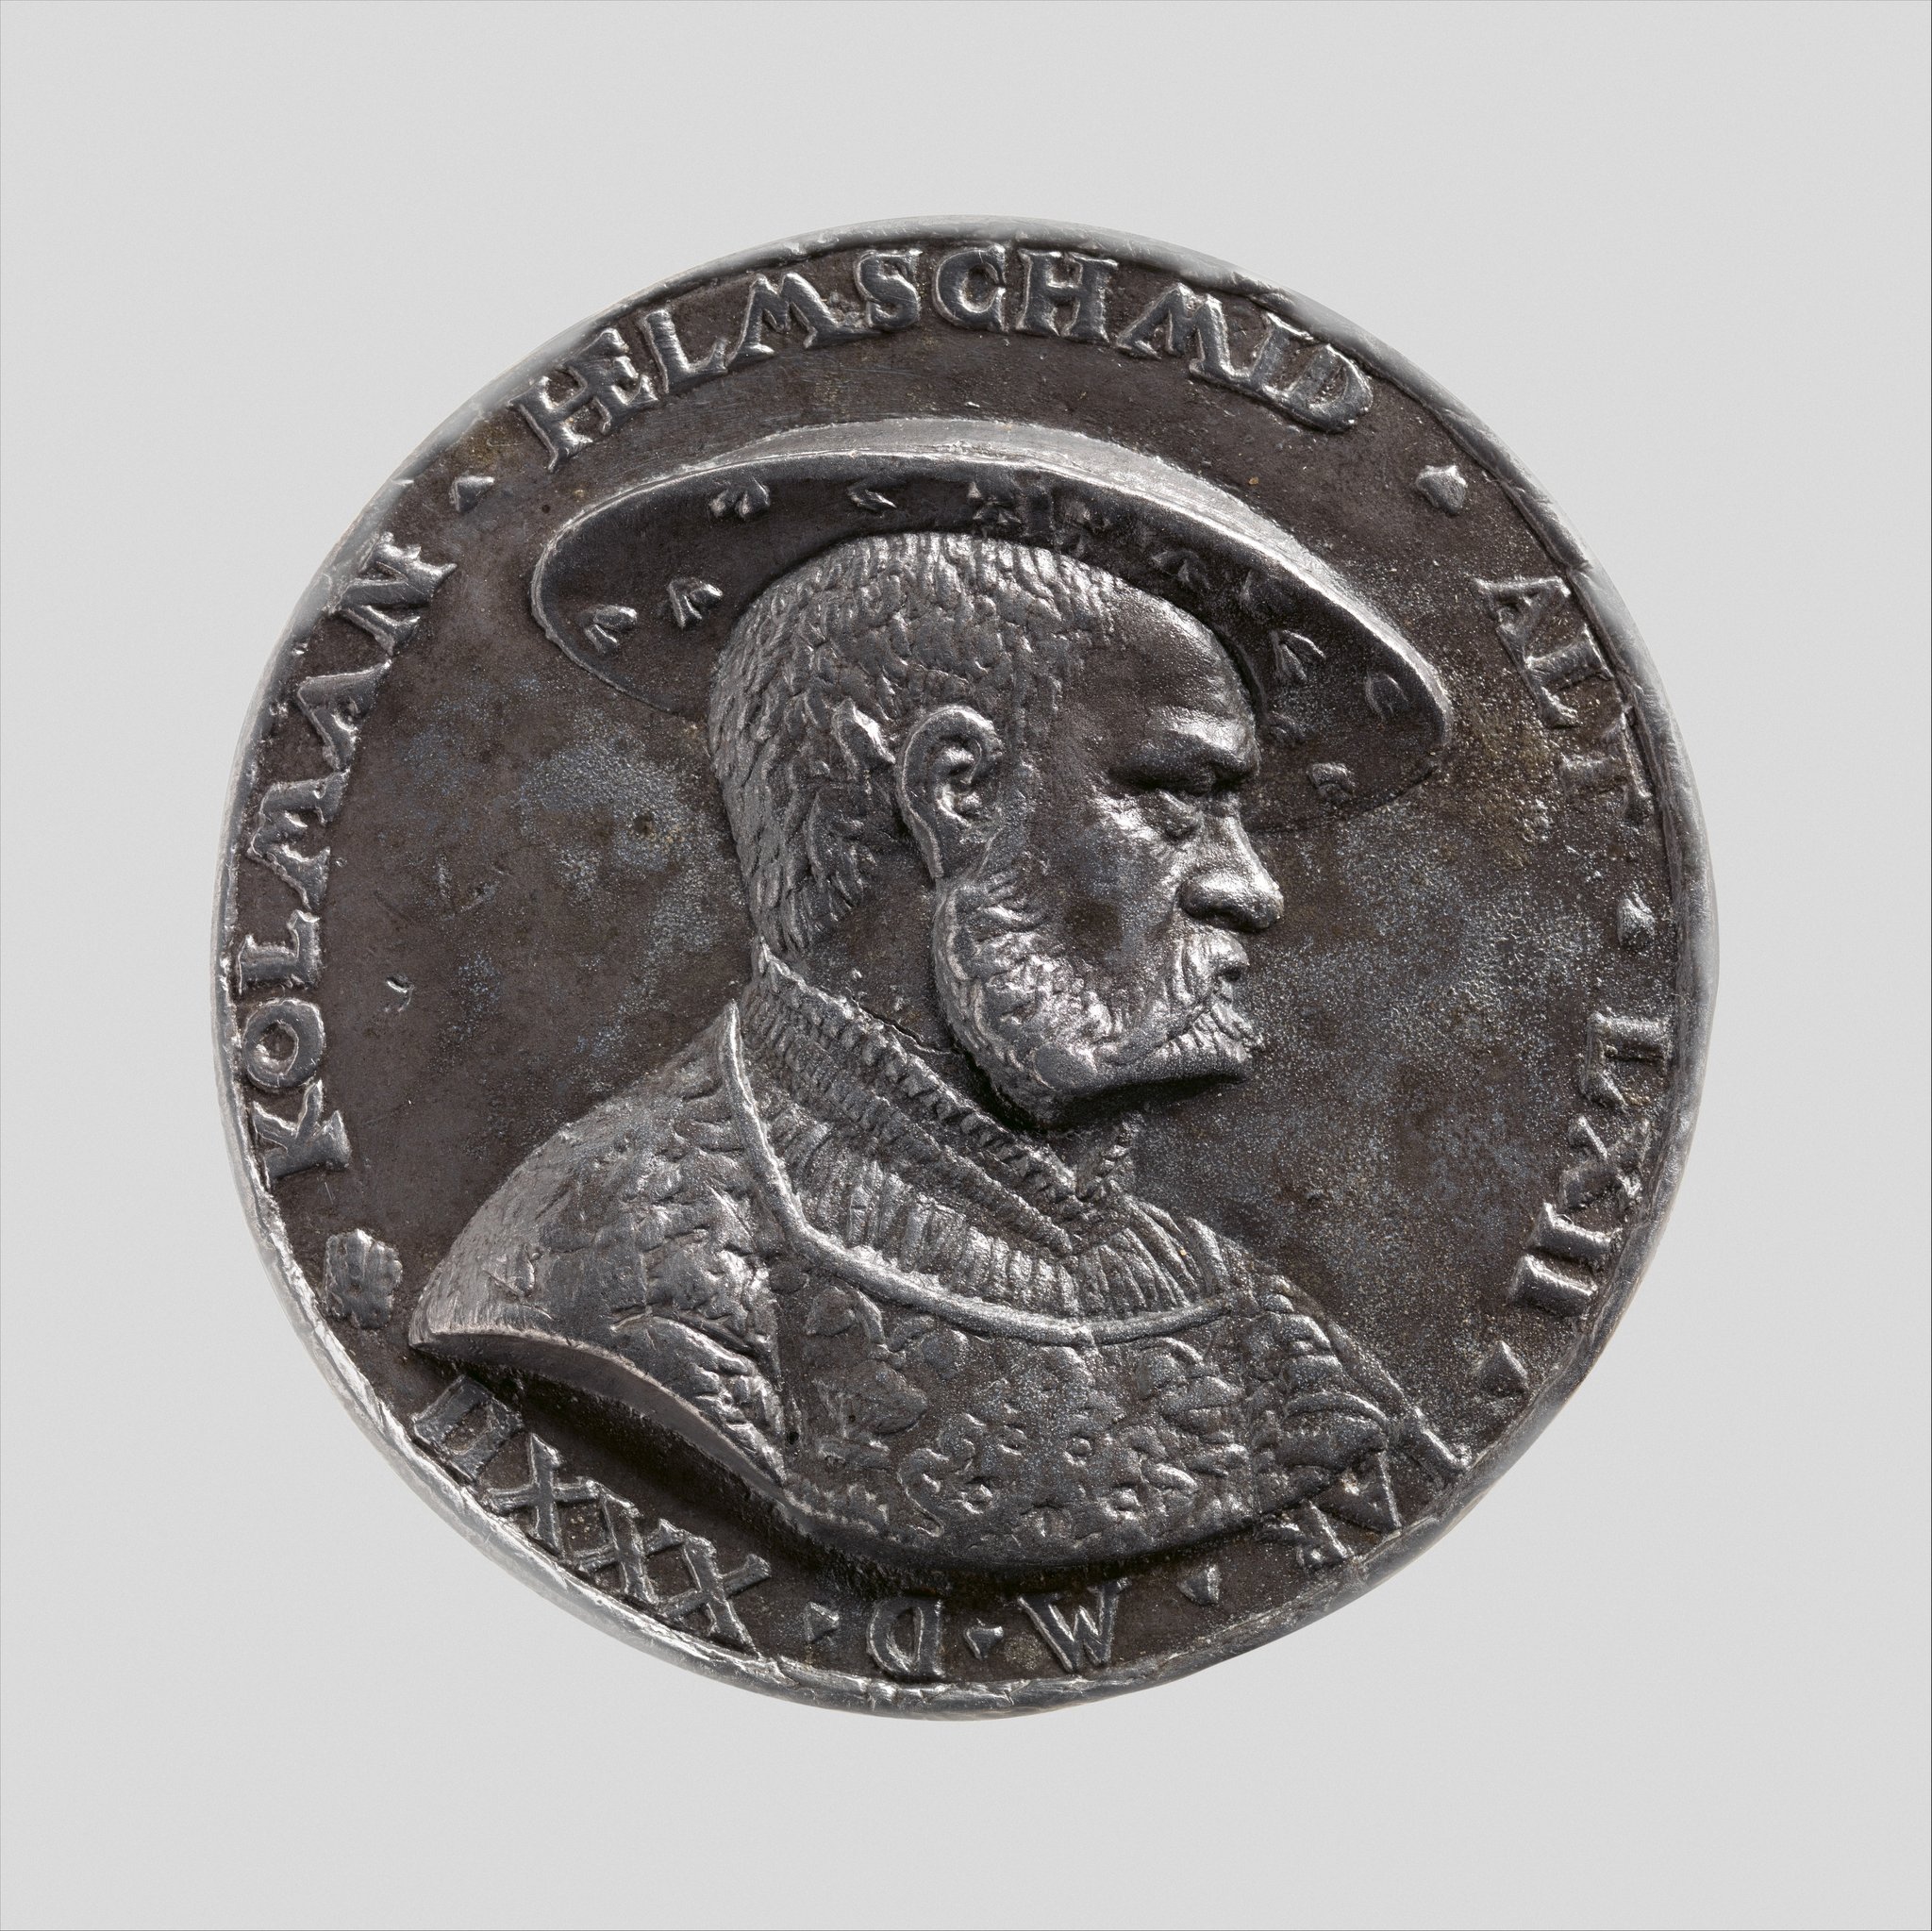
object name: medal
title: Medal of Kolman Helmschmid (1471–1532)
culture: german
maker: hans kels the younger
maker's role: designer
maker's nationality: german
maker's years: 1508-1565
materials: lead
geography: germany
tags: men,profiles